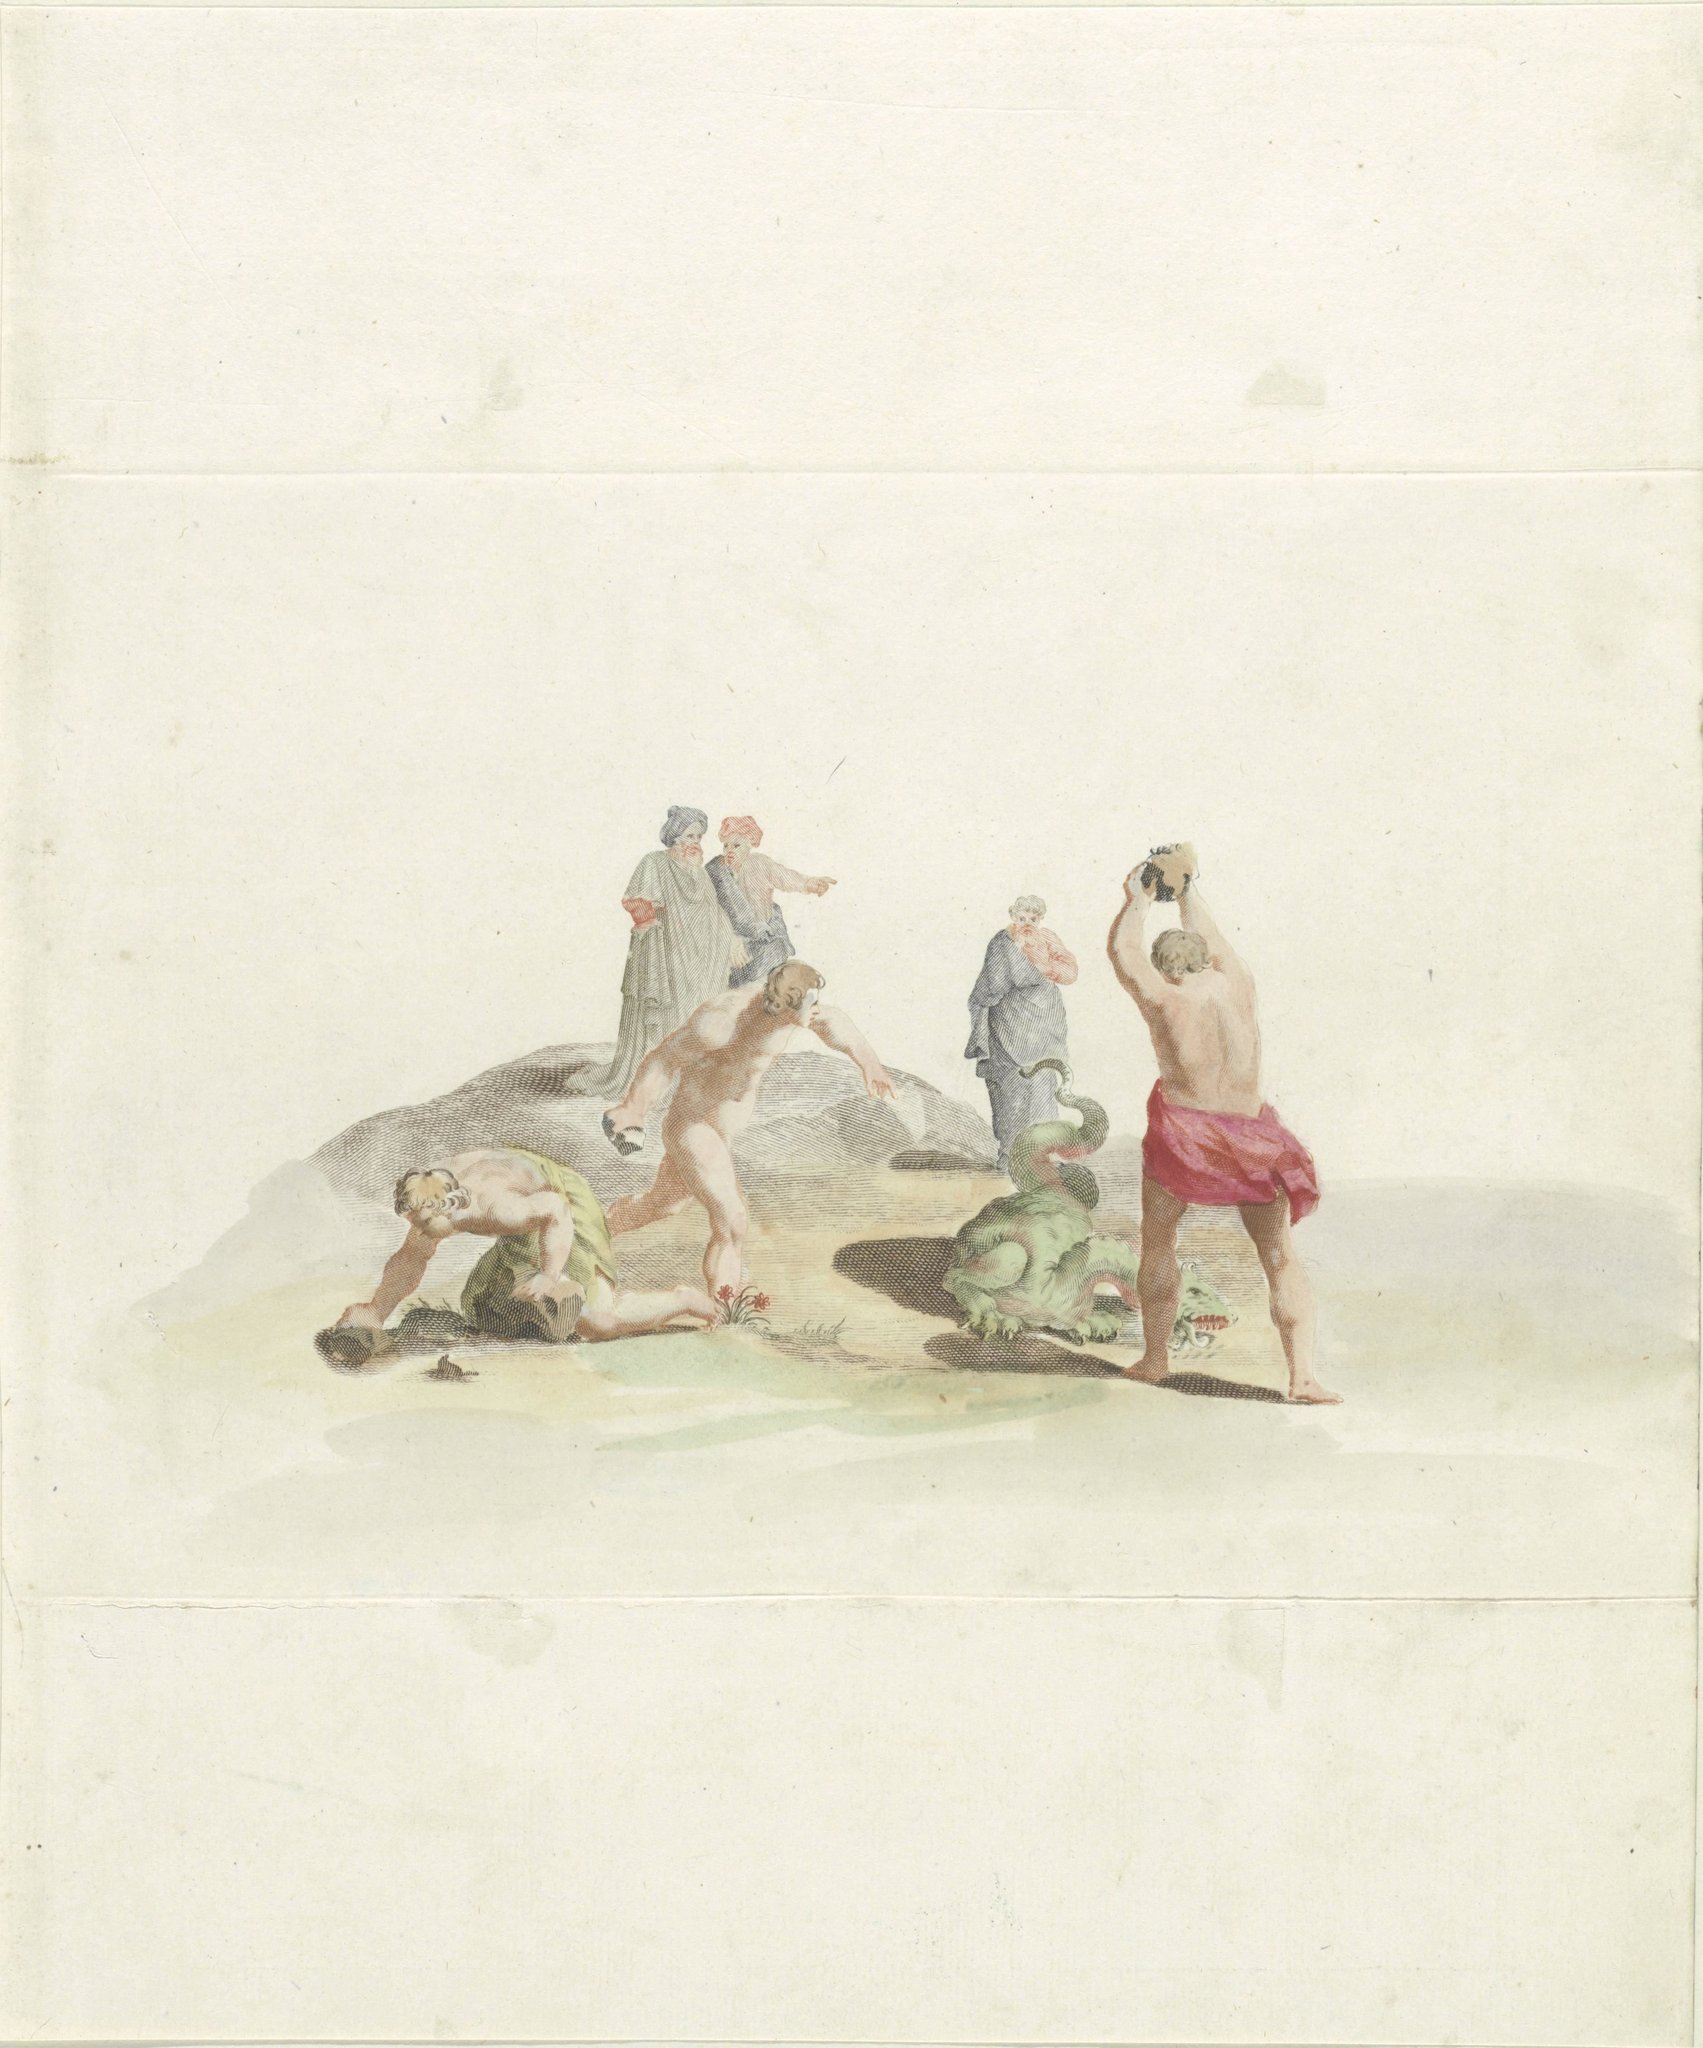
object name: print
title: Drie mannen stenigen een draak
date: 1688-1698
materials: paper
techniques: printing, engraving, hand coloring, lithography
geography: netherlands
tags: dragon (+ animal killed by man)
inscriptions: collector's mark: Lugt 2228, collector's mark: Lugt 2760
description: Drie mannen stenigen een draak, terwijl drie geklede mannen toekijken.